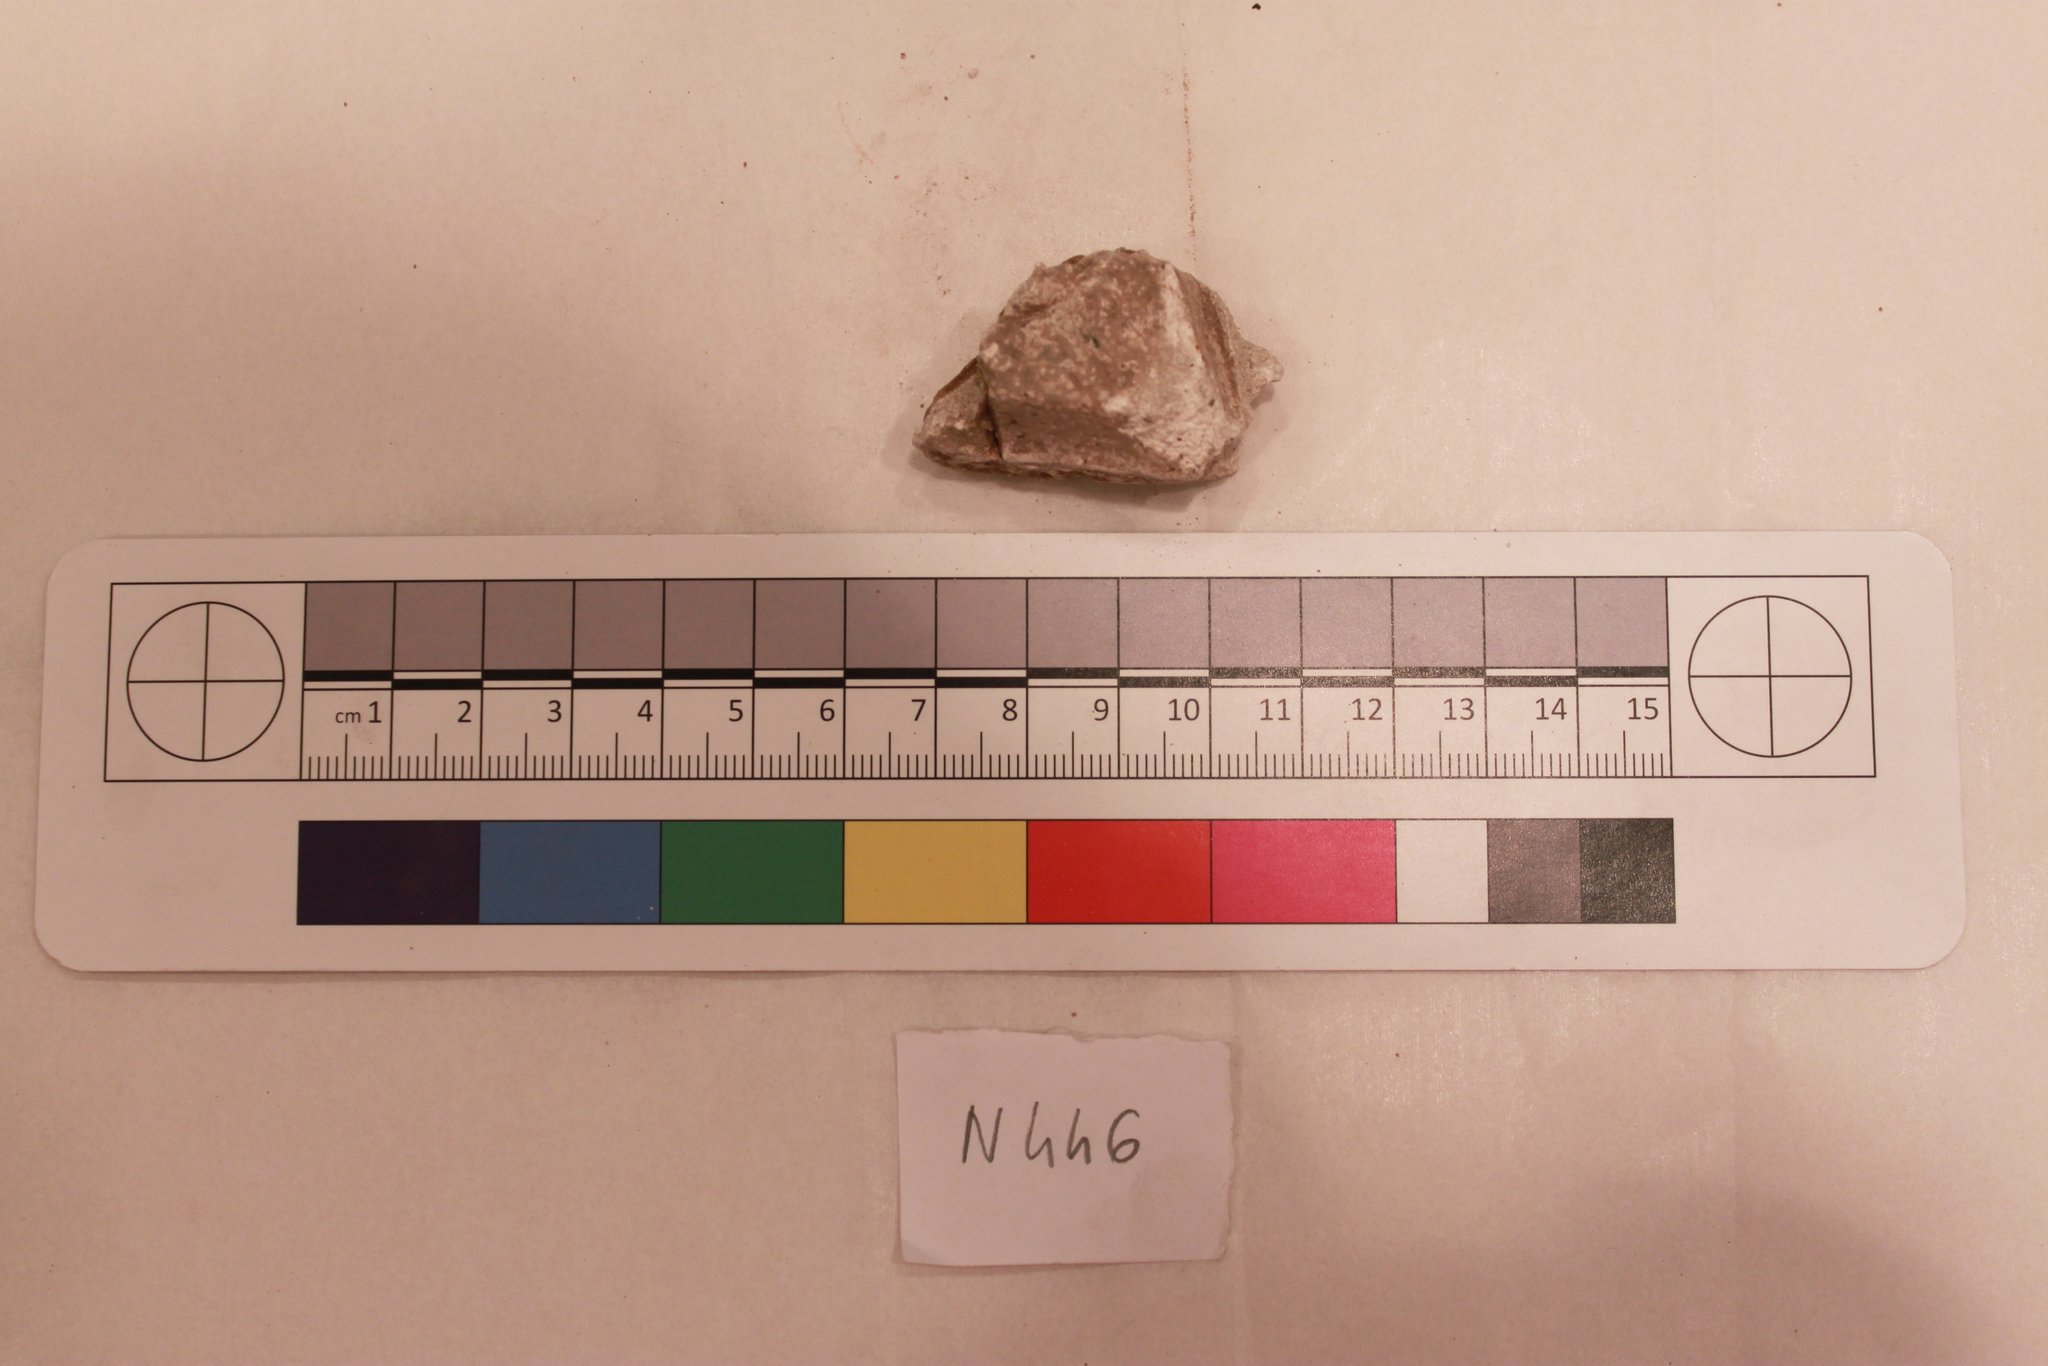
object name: fragment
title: Stucco Fragment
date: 701-1200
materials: plaster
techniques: carving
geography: iran